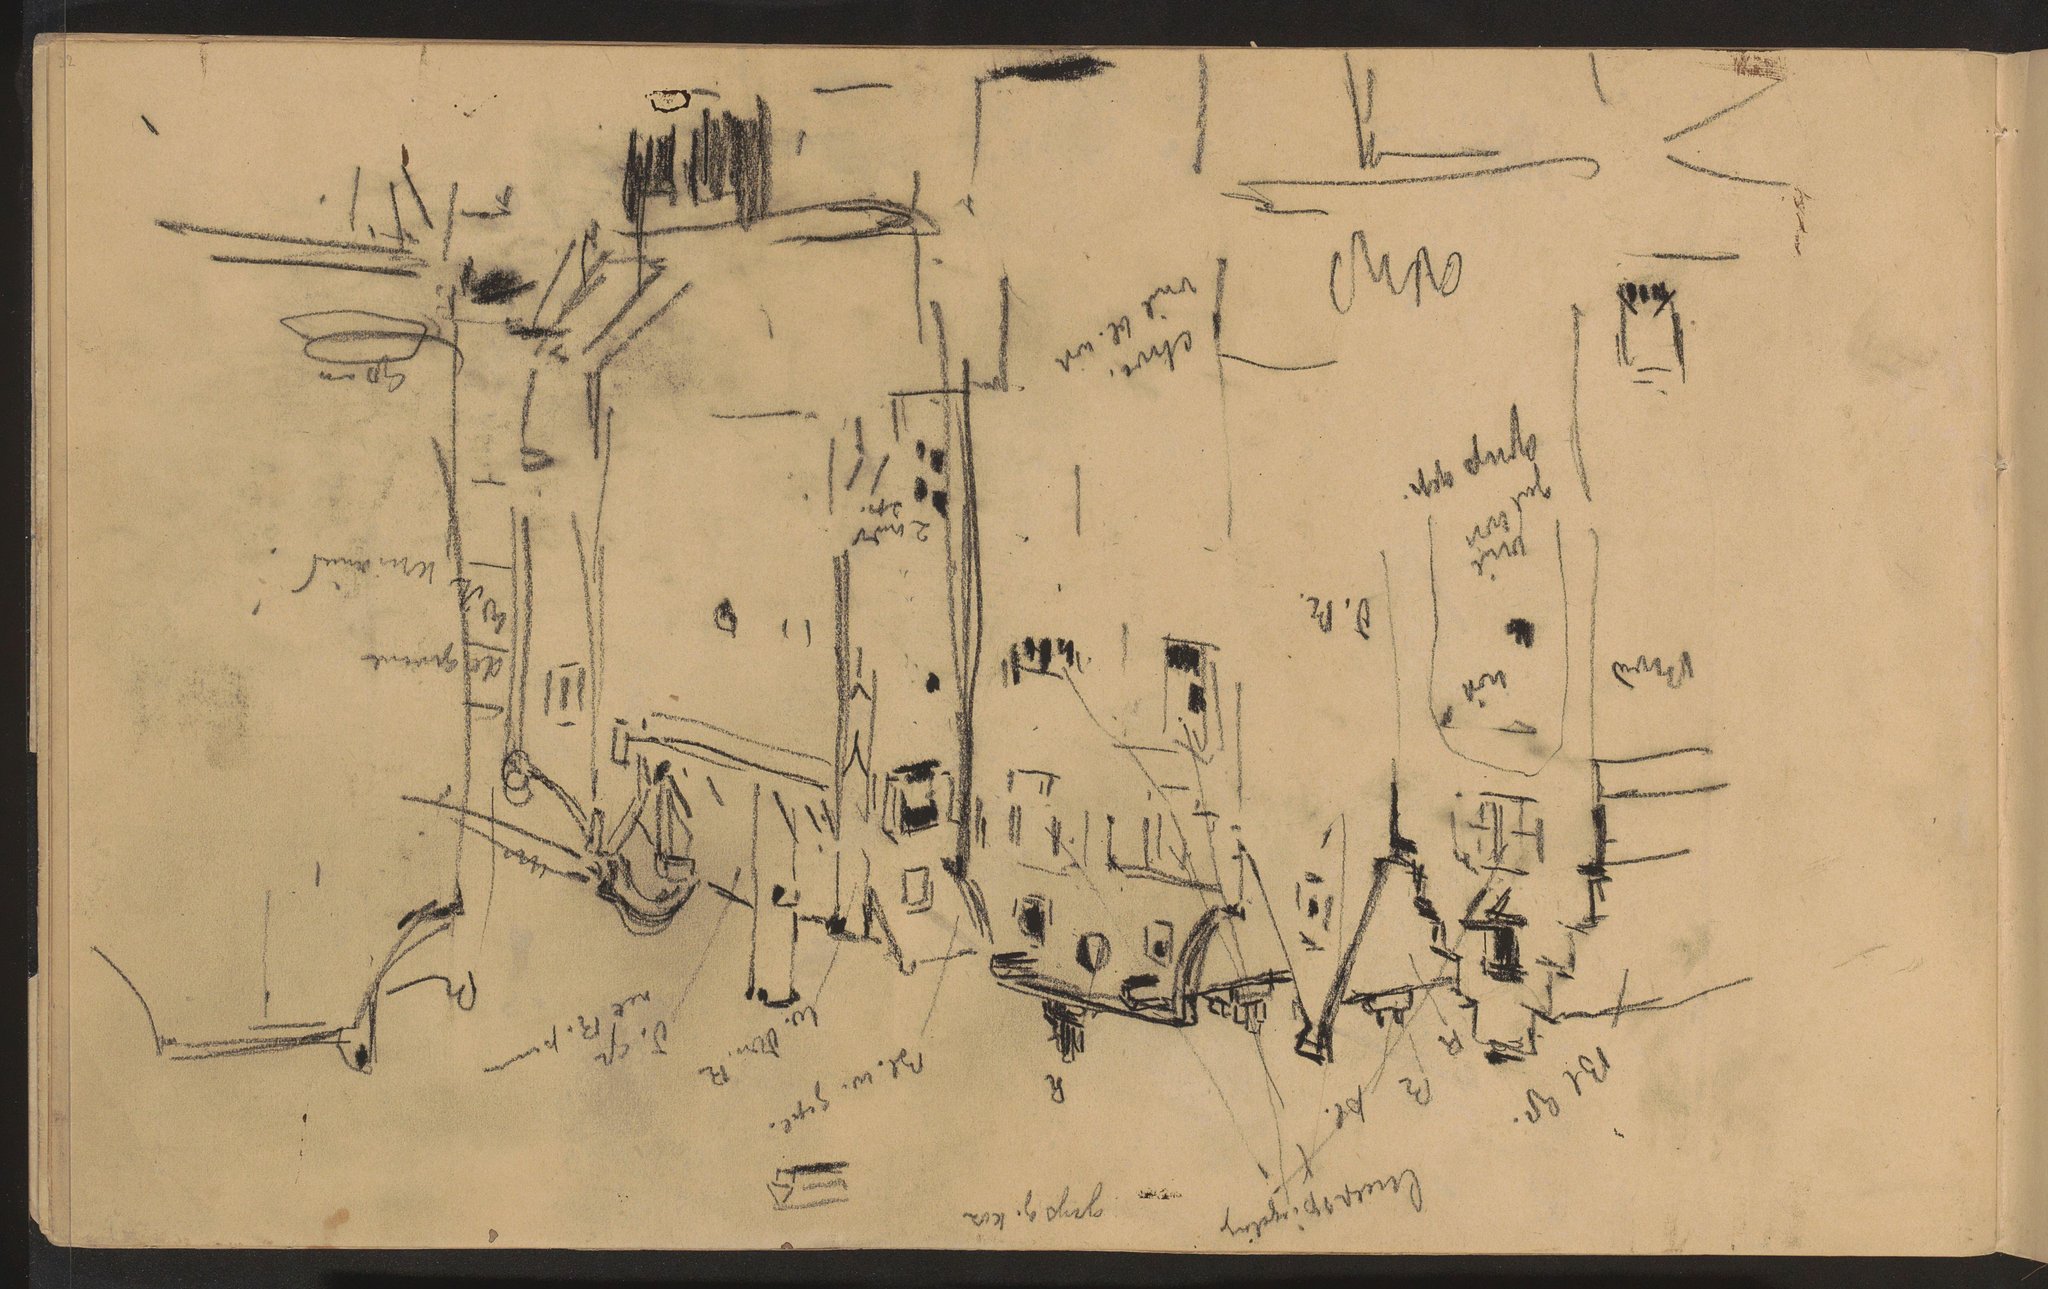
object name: sketchbook leaf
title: Gezicht op de Oudezijds Kolk te Amsterdam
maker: willem witsen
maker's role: draughtsman, painter, print maker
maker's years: 1860-1923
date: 1897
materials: chalk, paper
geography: amsterdam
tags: urban housing, canals, waters (in city)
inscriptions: annotation: ‘weerspiegeling/ kruidenier!’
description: Voorstudie voor de ets 'Oudezijds Kolk', ca. 1897.